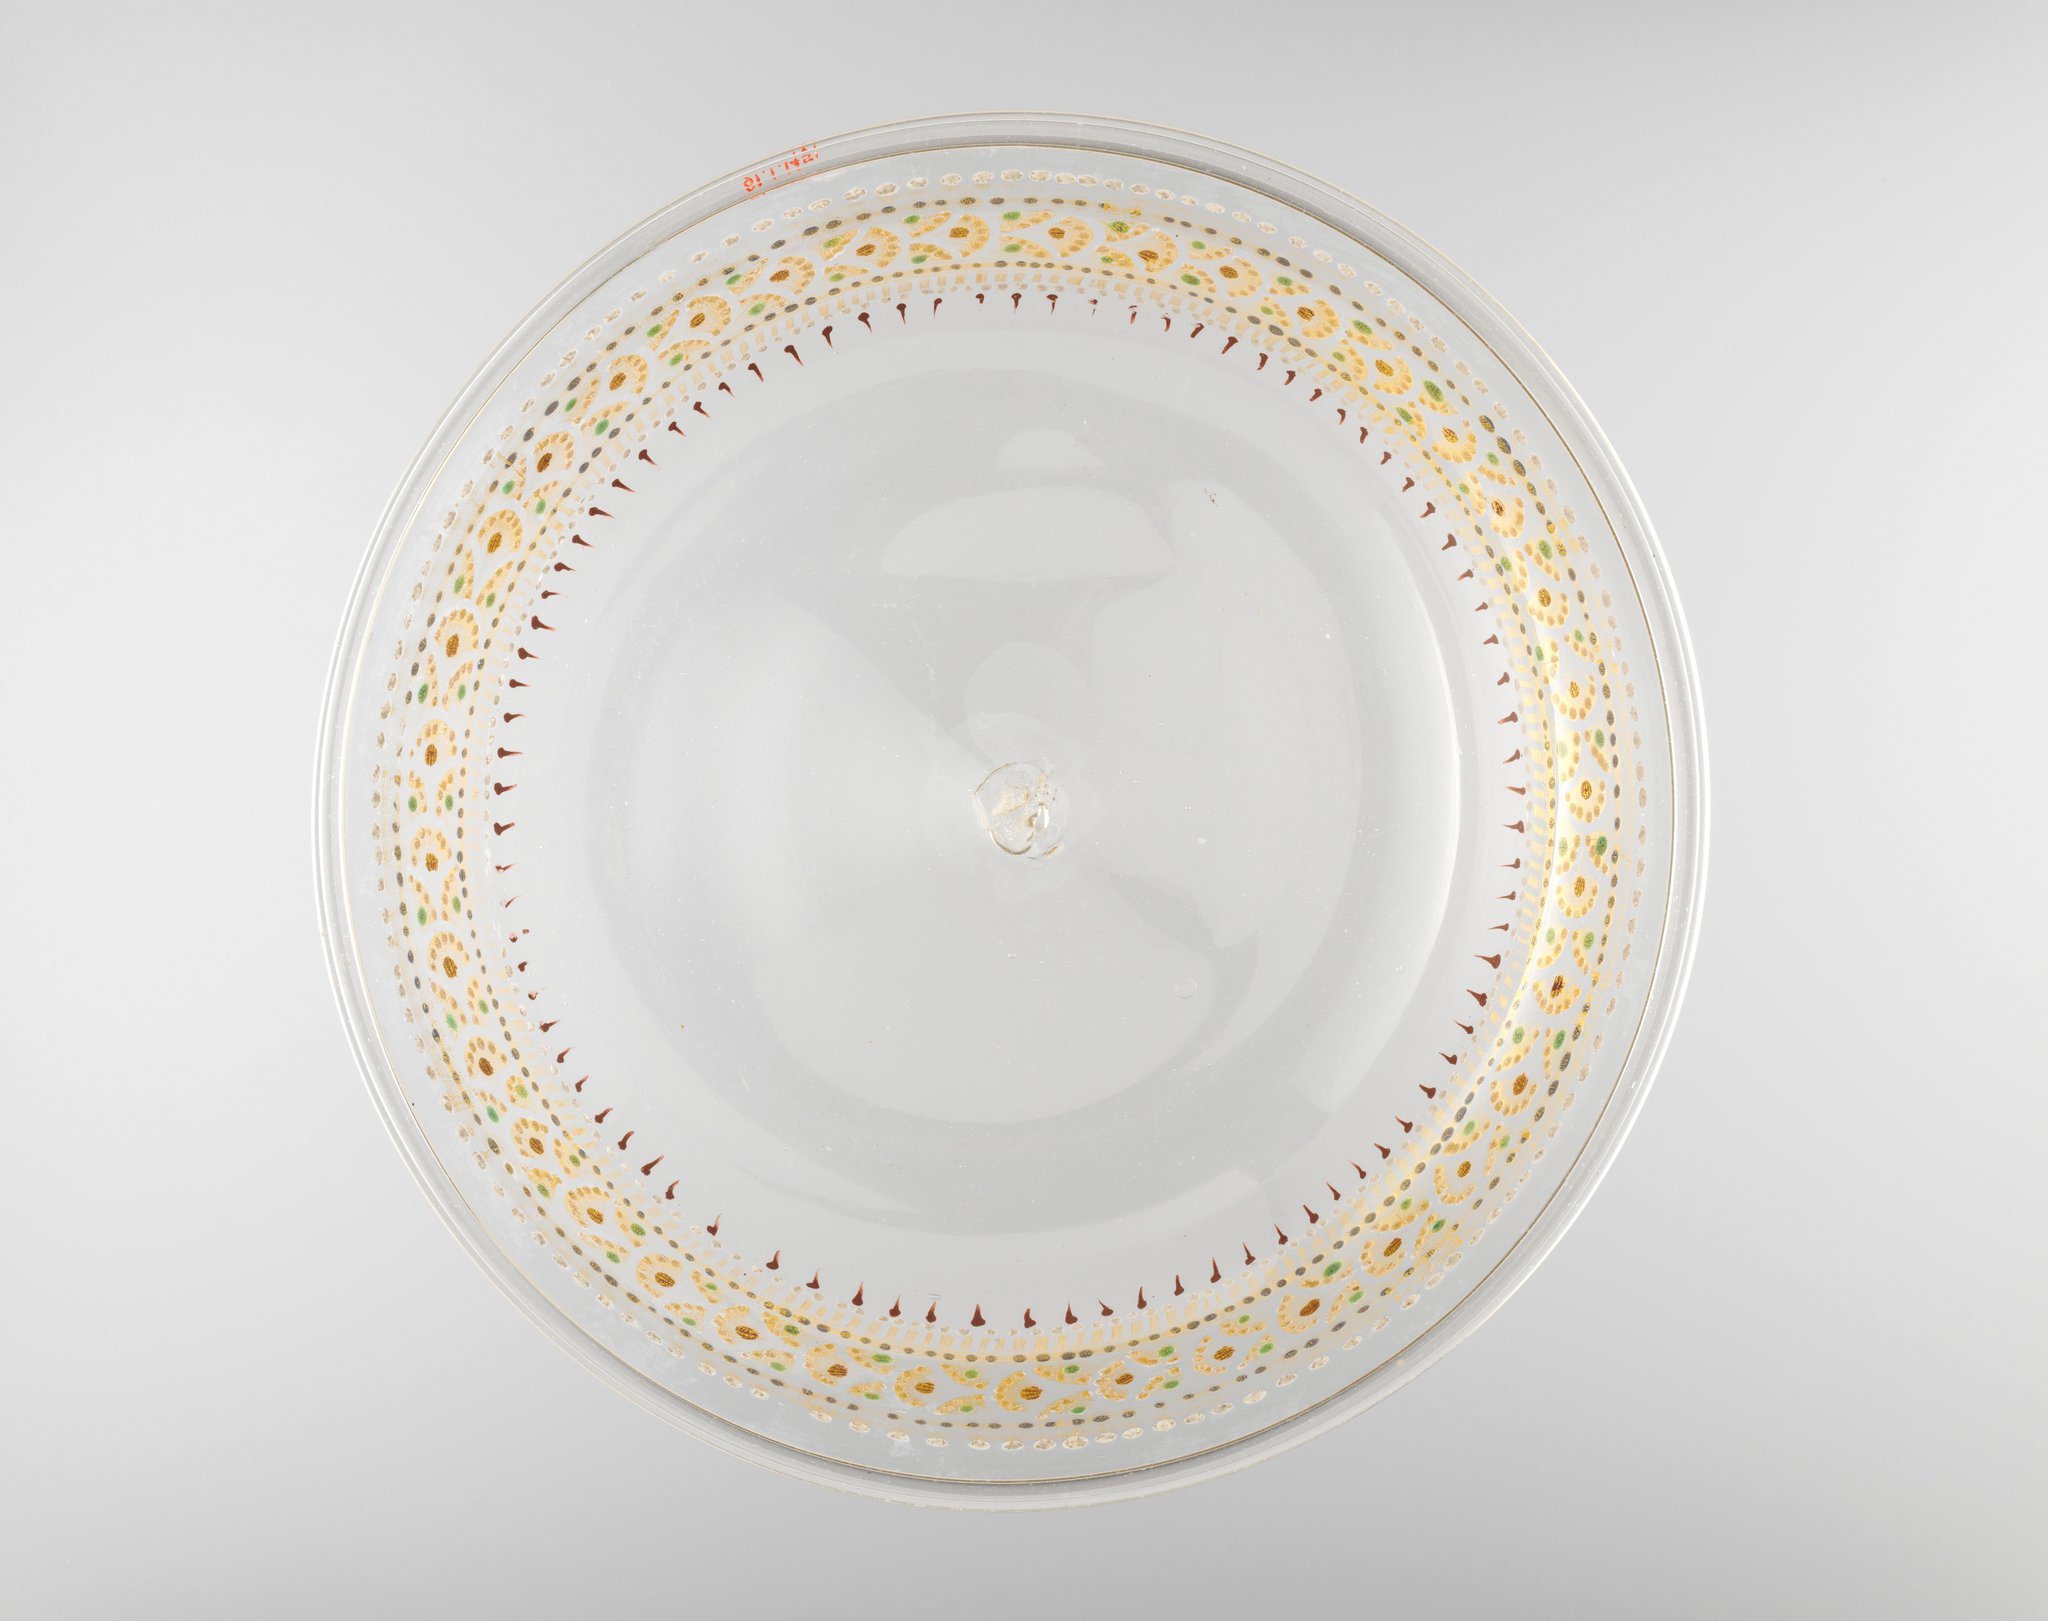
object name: plateau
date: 1501-1600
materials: gilt, glass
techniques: enamel